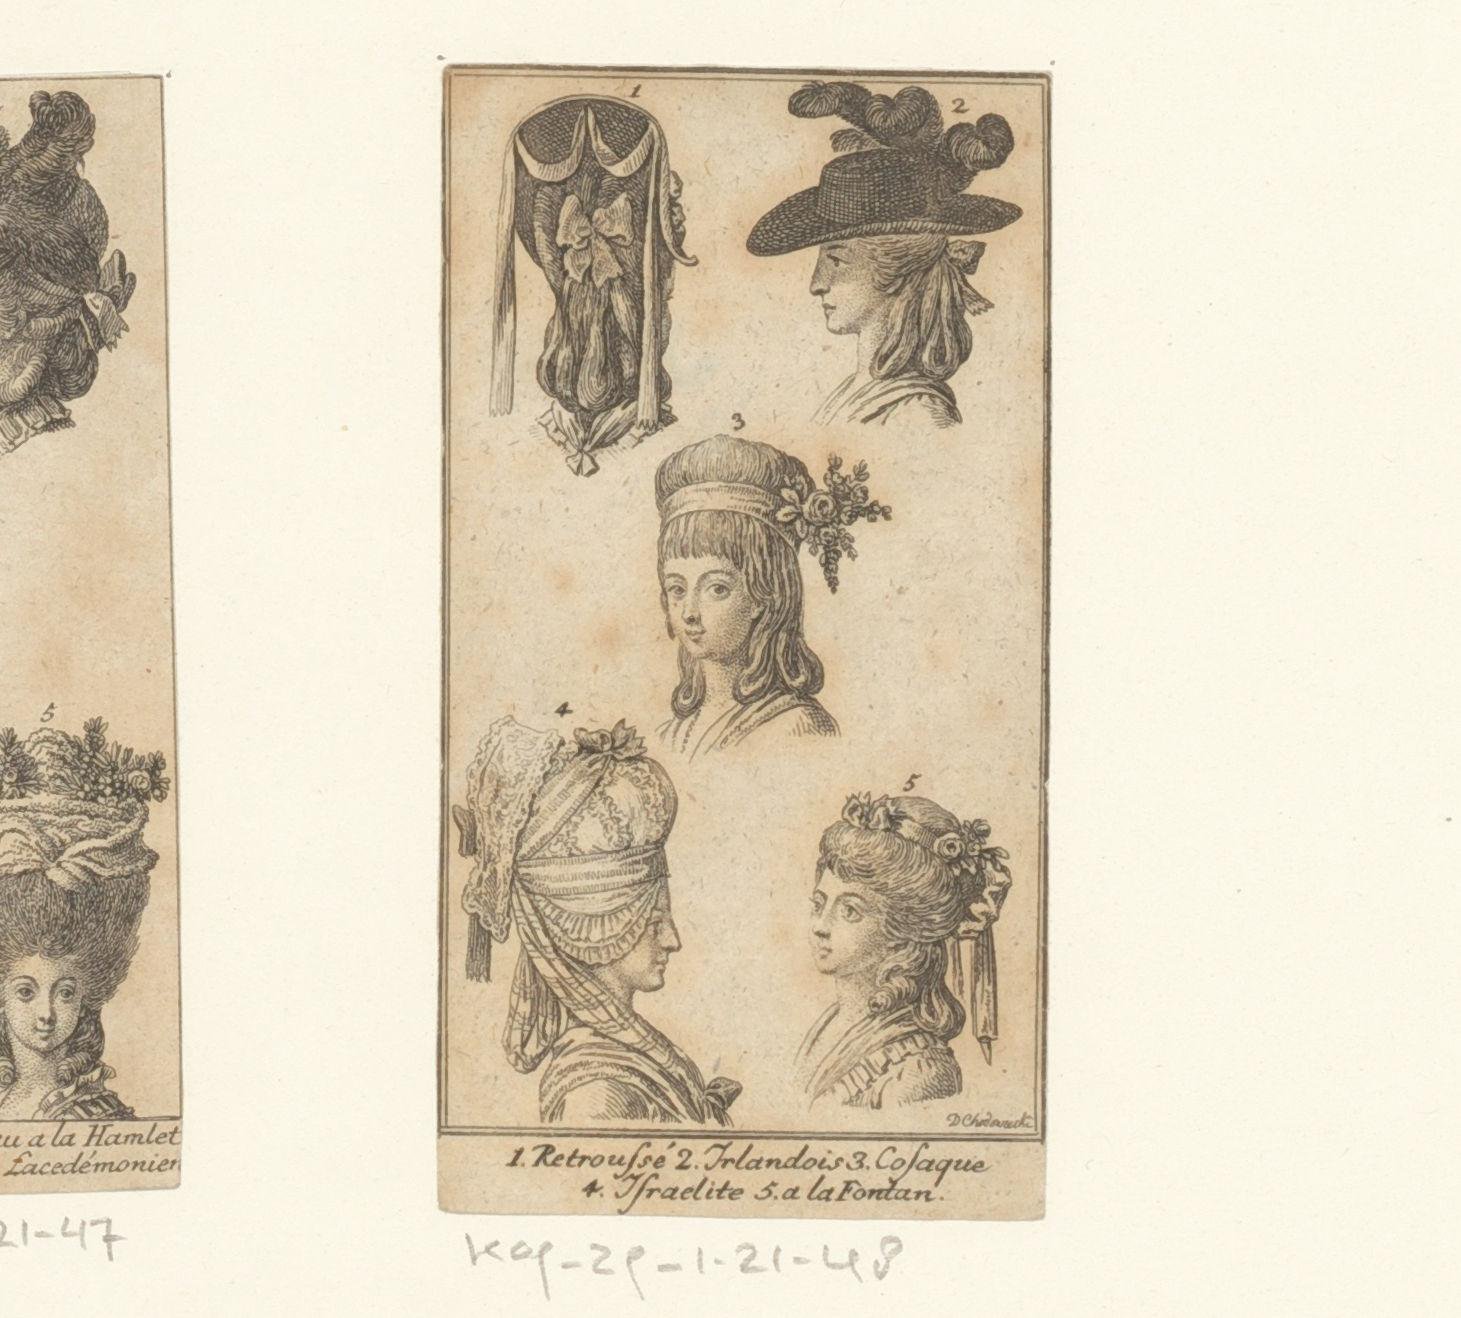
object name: print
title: Vijf vrouwen met verschillende haarstijlen met verschillende hoeden en linten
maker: daniel nikolaus chodowiecki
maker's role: draughtsman, print maker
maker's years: 1726-1801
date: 1778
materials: paper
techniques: etching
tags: styles of hairdress - aa - ~ women, hairdress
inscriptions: collector's mark: Lugt 1641, stamp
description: Vijf vrouwen met verschillende haarstijlen volgens de Berlijnse mode. Onderaan worden de verschillende stijlen benoemd: 1. Retroussé 2. Irlandois 3. Cosaque 4. Israelite 5. a la Fontan. Onderwerpsrubrieken binnen de Atlas Zeden en Gewoonten: Zeden en Gewoonten in Engeren Zin, De Kleeding, Kleederdrachten (tijdvakken), De 18de eeuw (de pruikentijd). Mannen en vrouwen.